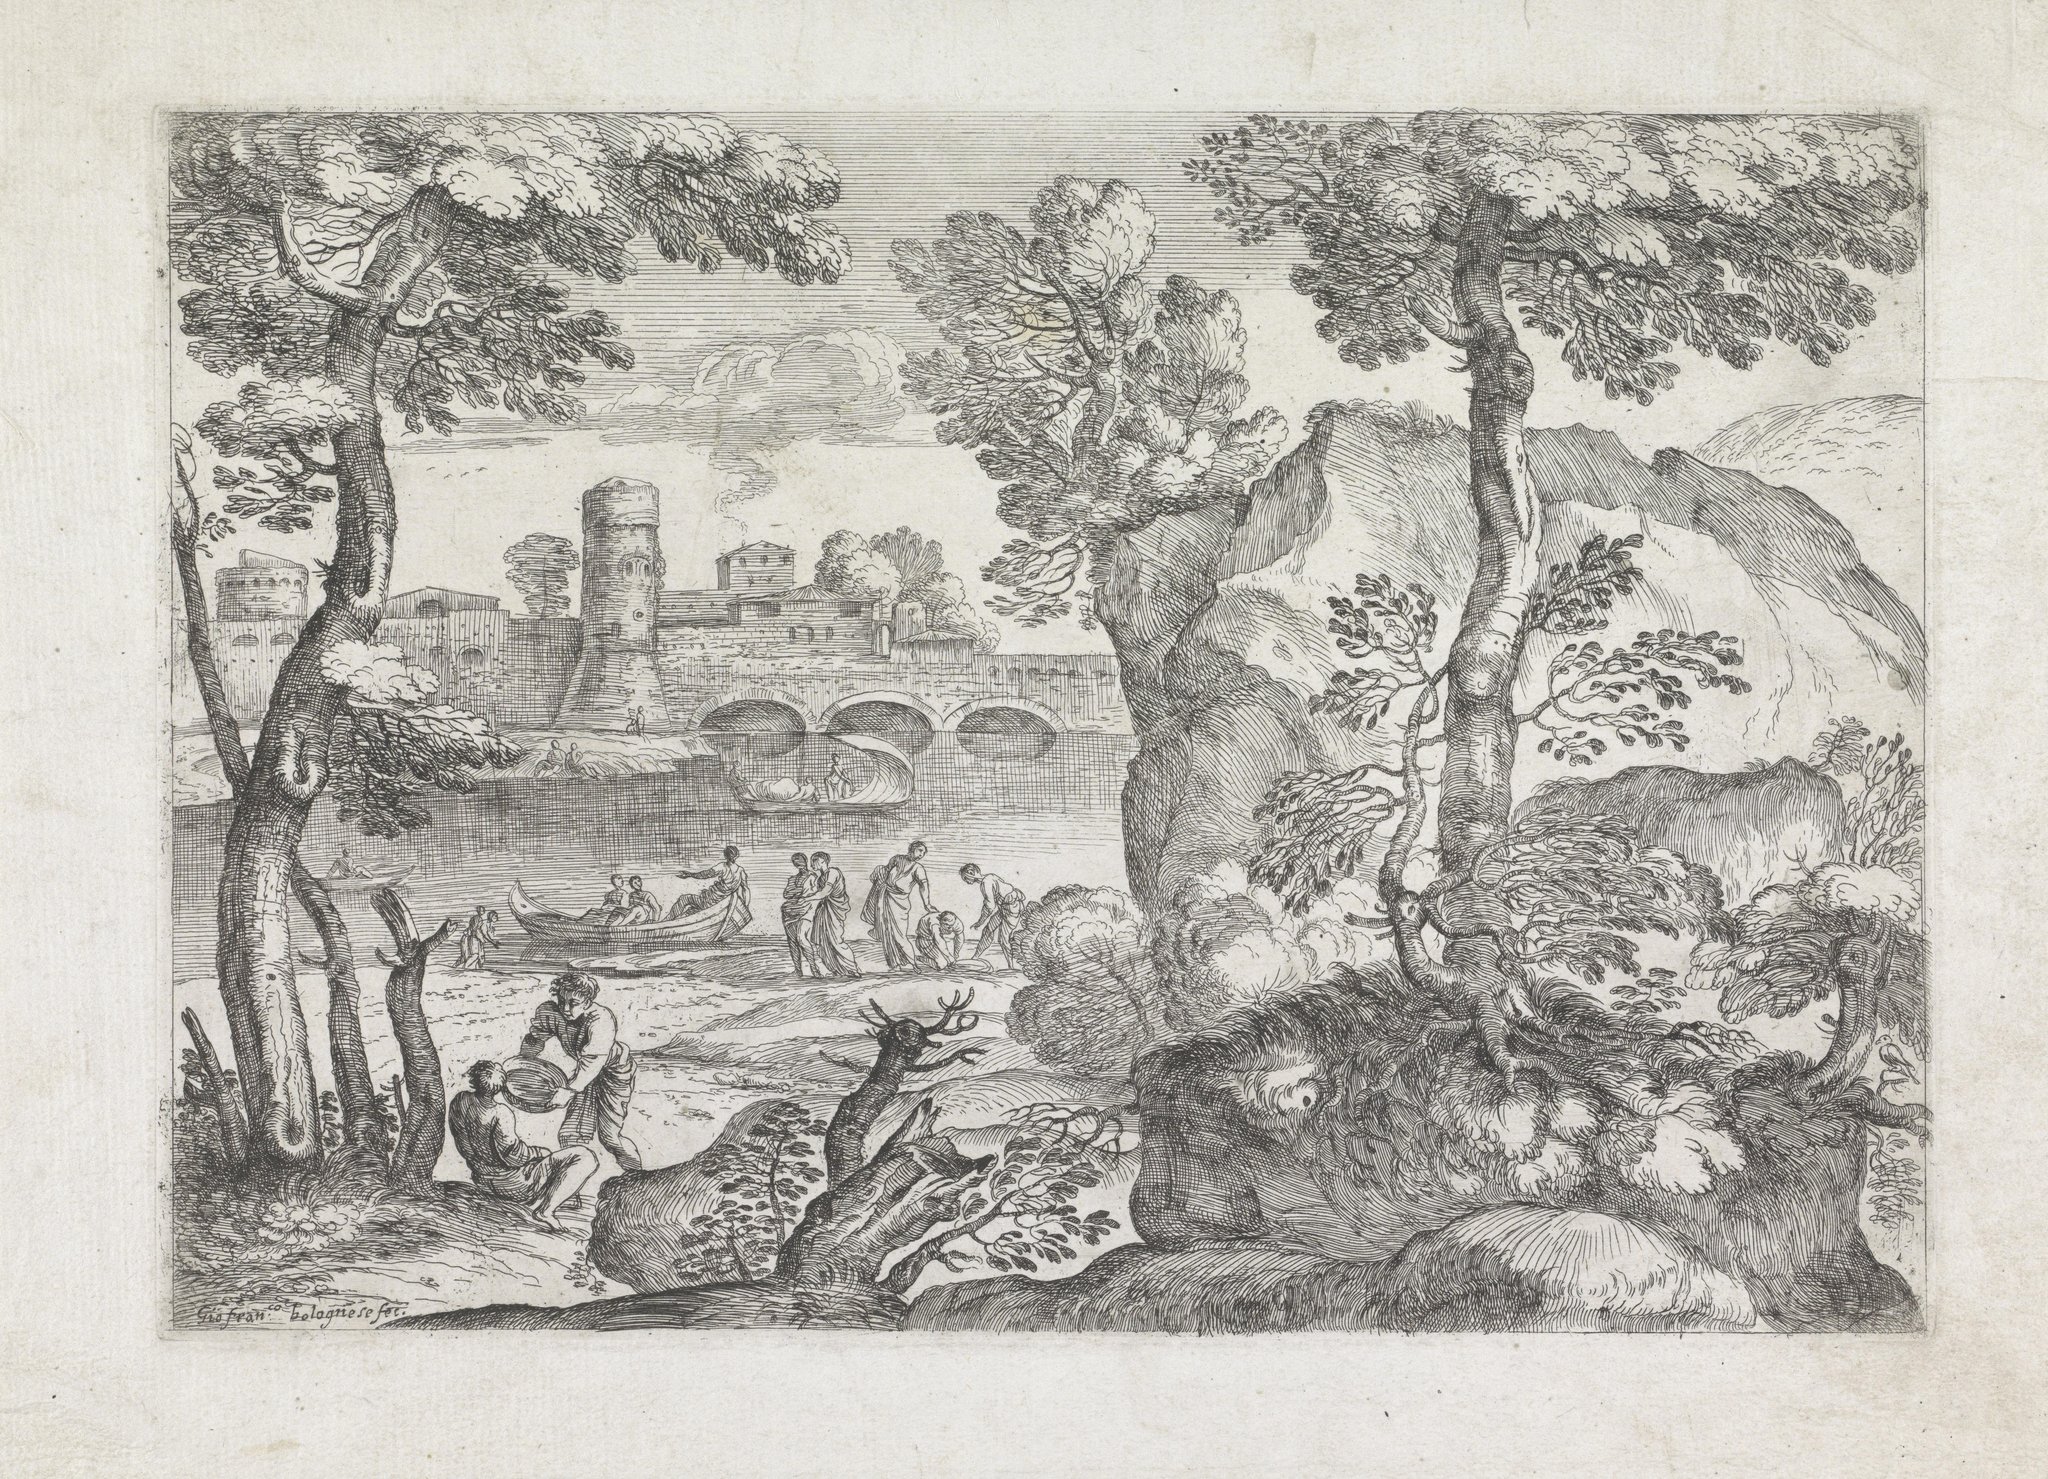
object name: print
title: Landschap met drie bootjes op een rivier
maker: giovanni francesco grimaldi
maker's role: draughtsman, print maker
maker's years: 1606-1680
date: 1616-1680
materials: paper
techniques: etching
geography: italy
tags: landscapes, river, landscape with bridge, viaduct or aqueduct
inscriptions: collector's mark: Lugt 240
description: Een rivierlandschap met nederzetting aan de waterkant en brug over de rivier. Op de rivier drie bootjes.